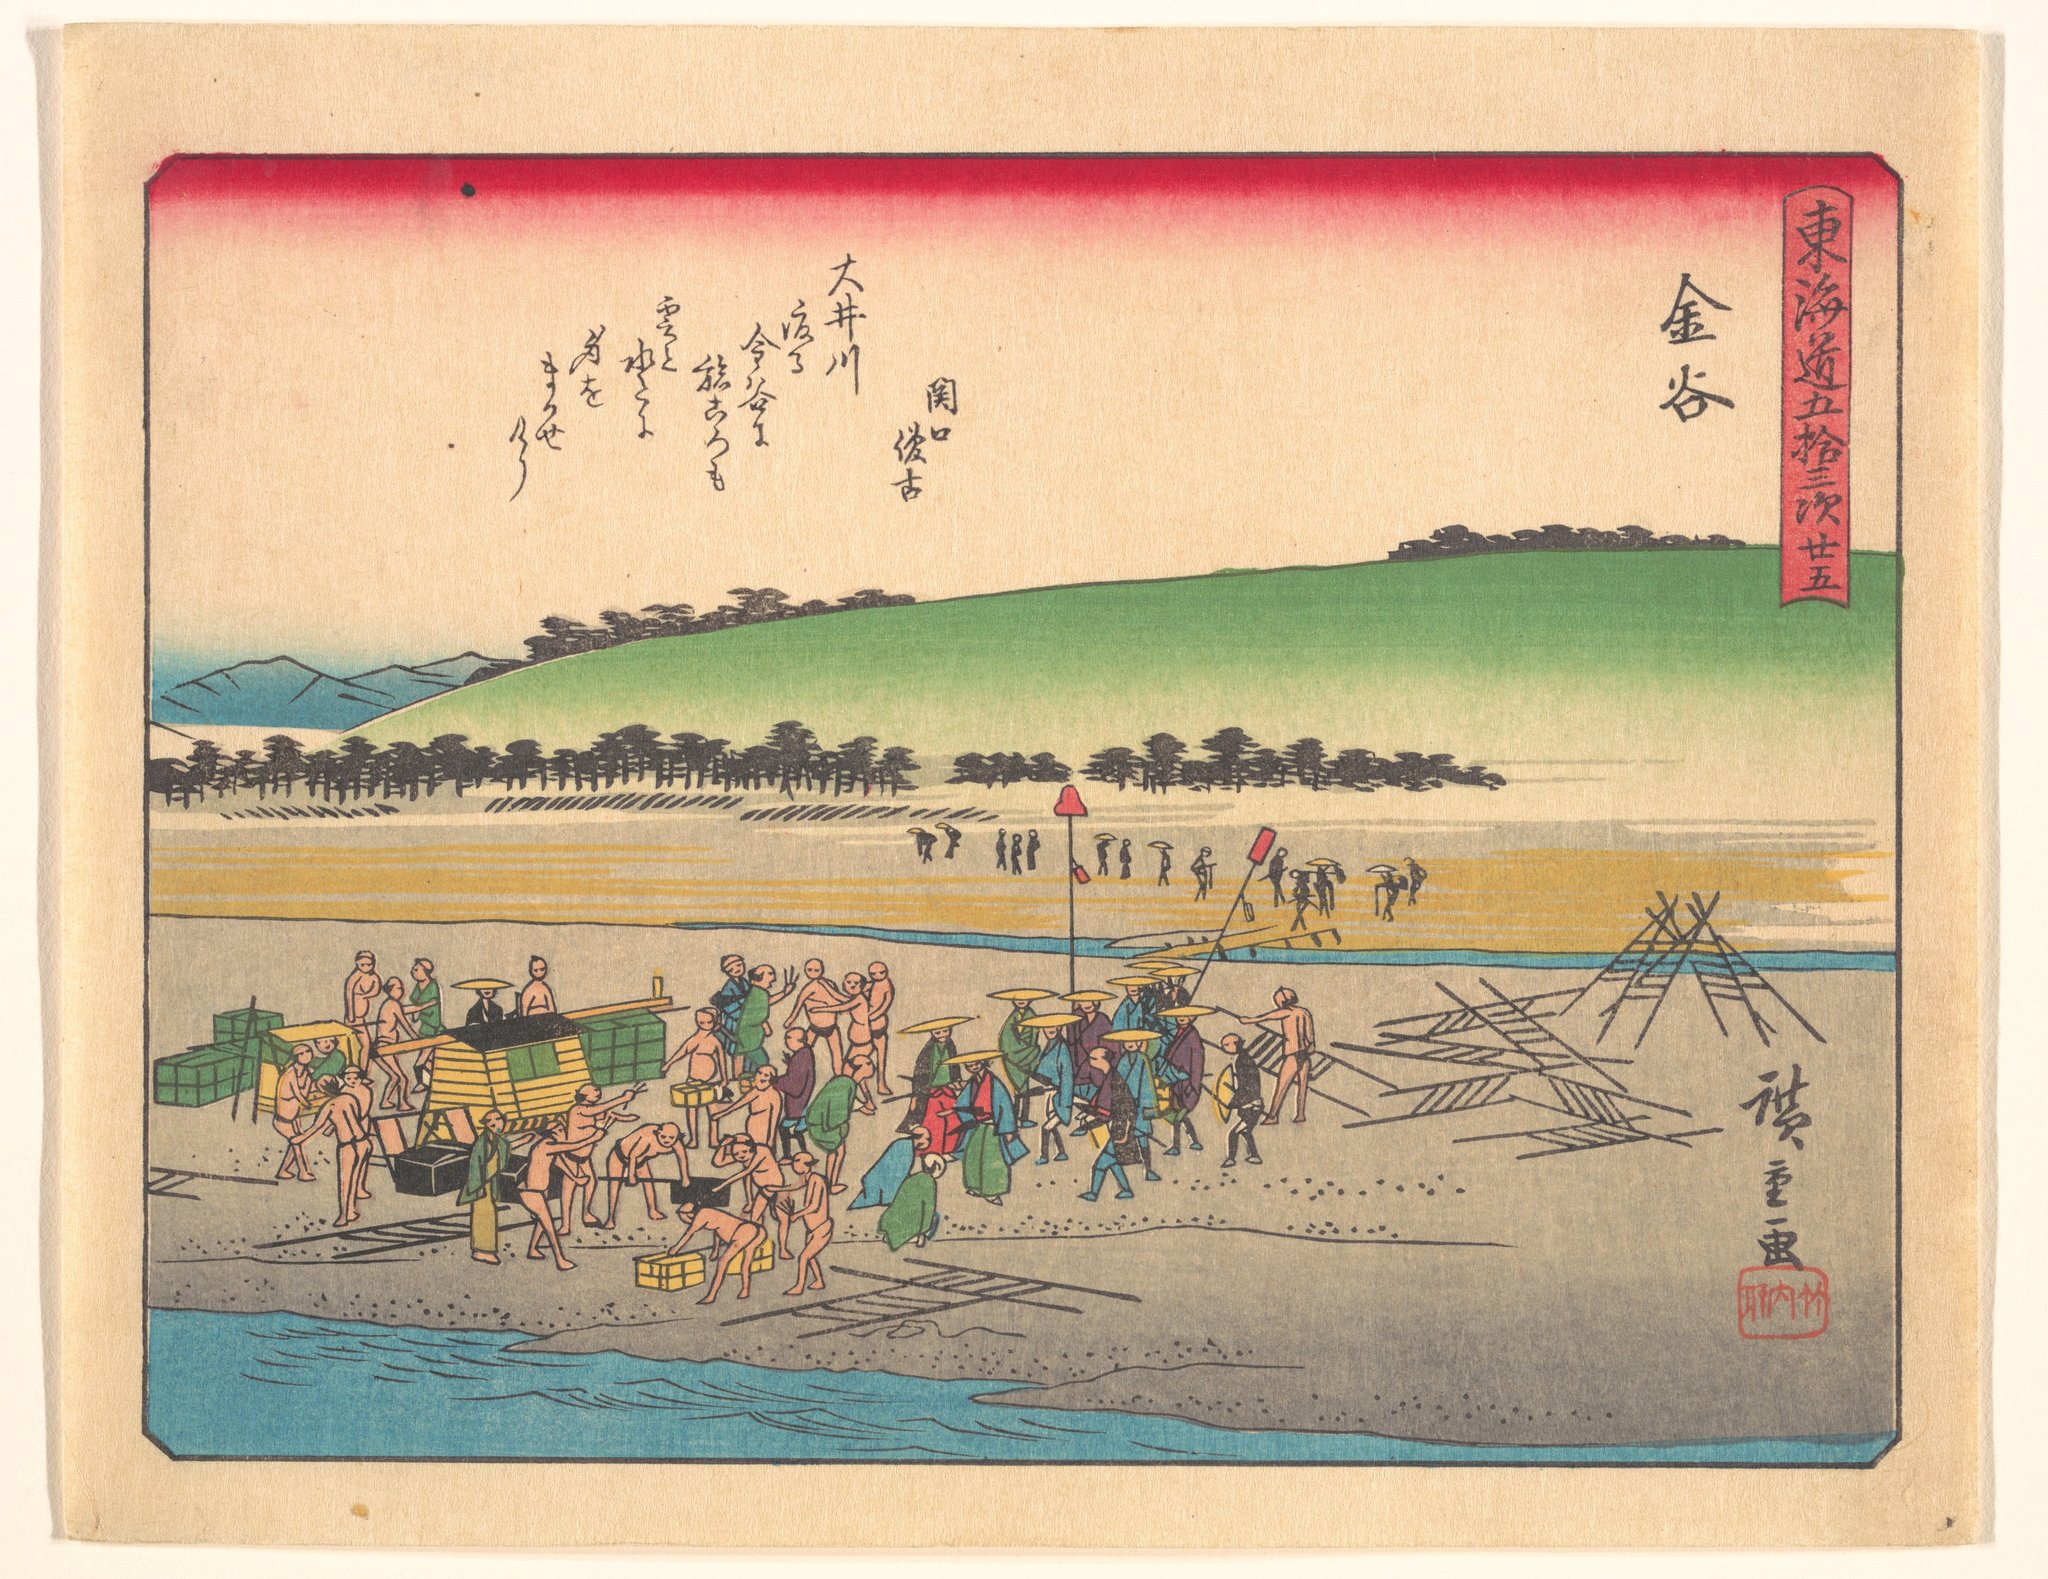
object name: print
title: 東海道五十三次 金谷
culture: japanese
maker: utagawa hiroshige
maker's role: artist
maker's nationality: japanese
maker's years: 1797-1858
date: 1901-1933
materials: ink, paper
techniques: woodblock print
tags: men,beaches,hills